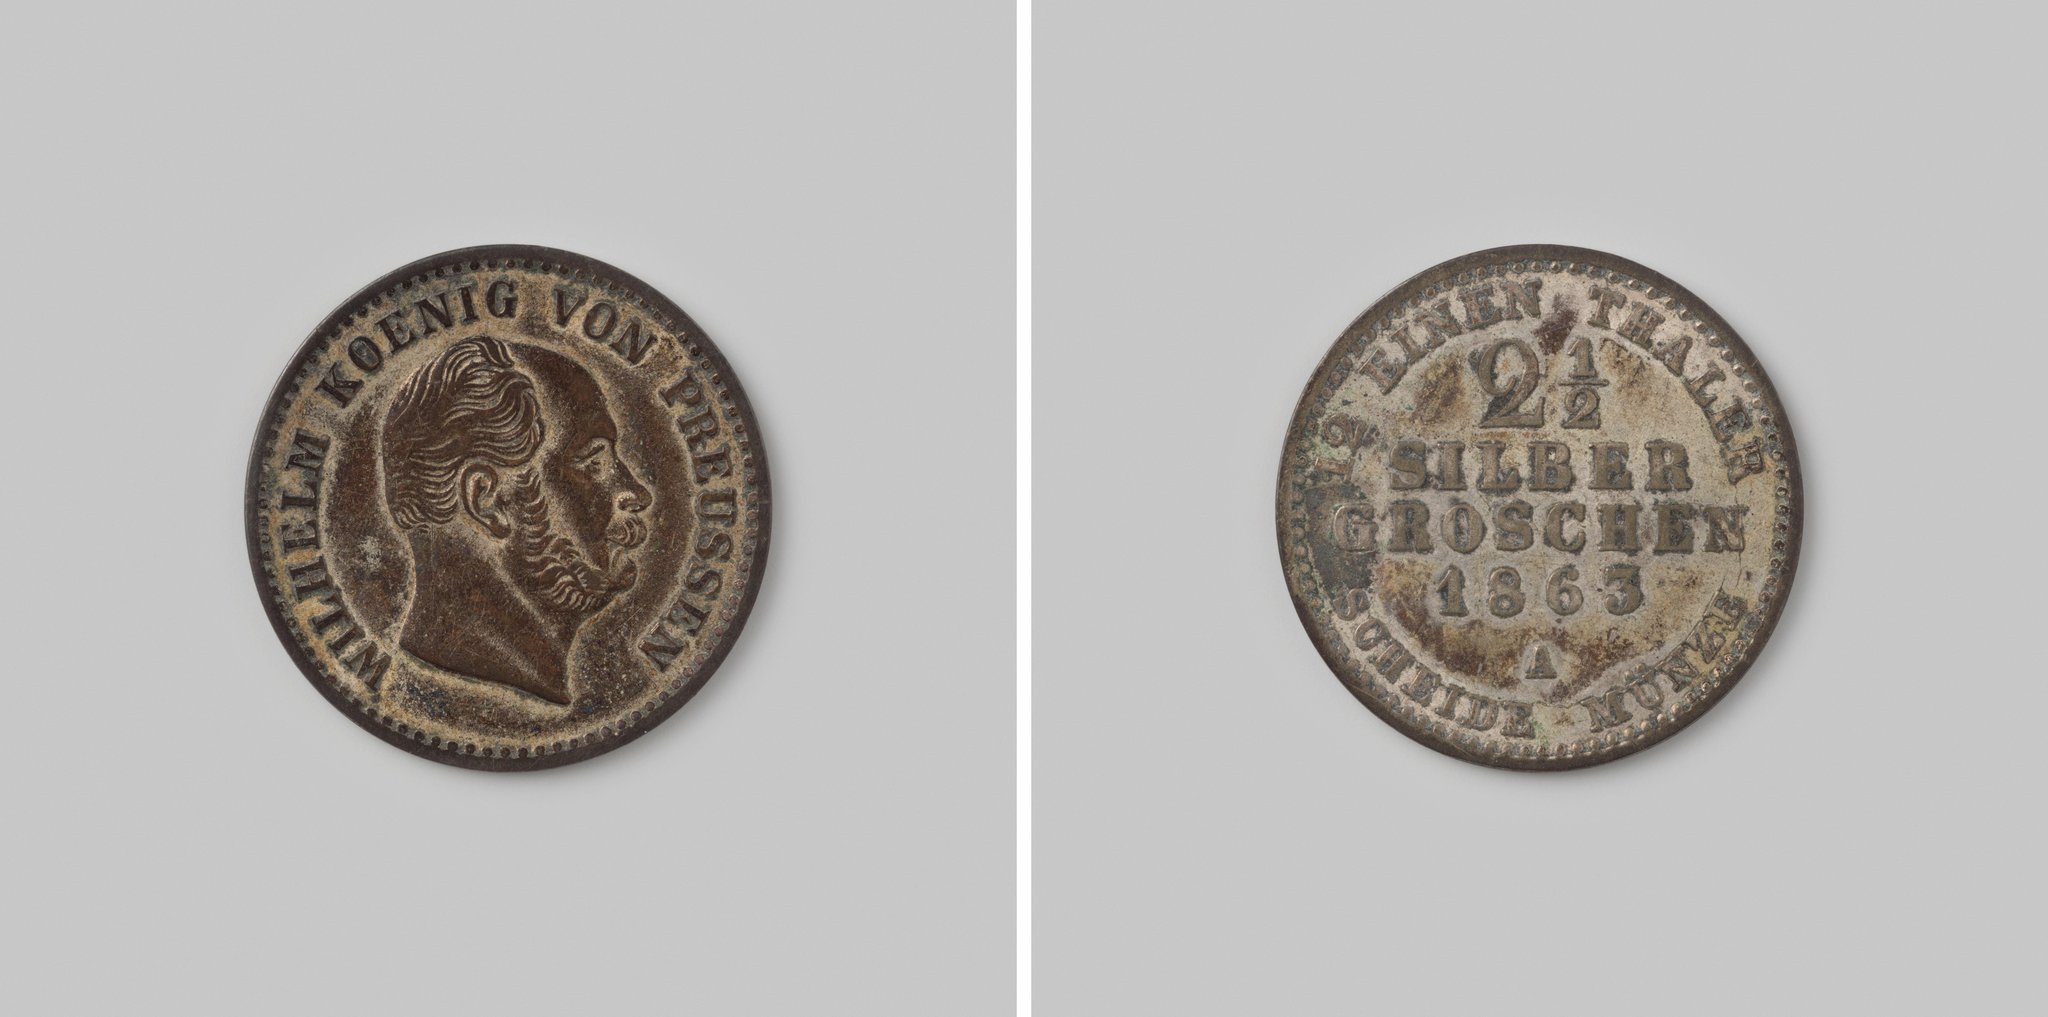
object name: twaalfde taler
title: Twaalfde taler uit Pruisen van Wilhelm I, 1863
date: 1863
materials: silver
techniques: striking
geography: berlin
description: Zilveren munt. Voorzijde: hoofd van de koning naar rechts. Keerzijde: Waarde-aanduiding: 2½ Silbergroschen in drie regels, waaronder jaartal. Daaronder letter A. Kartelrand.